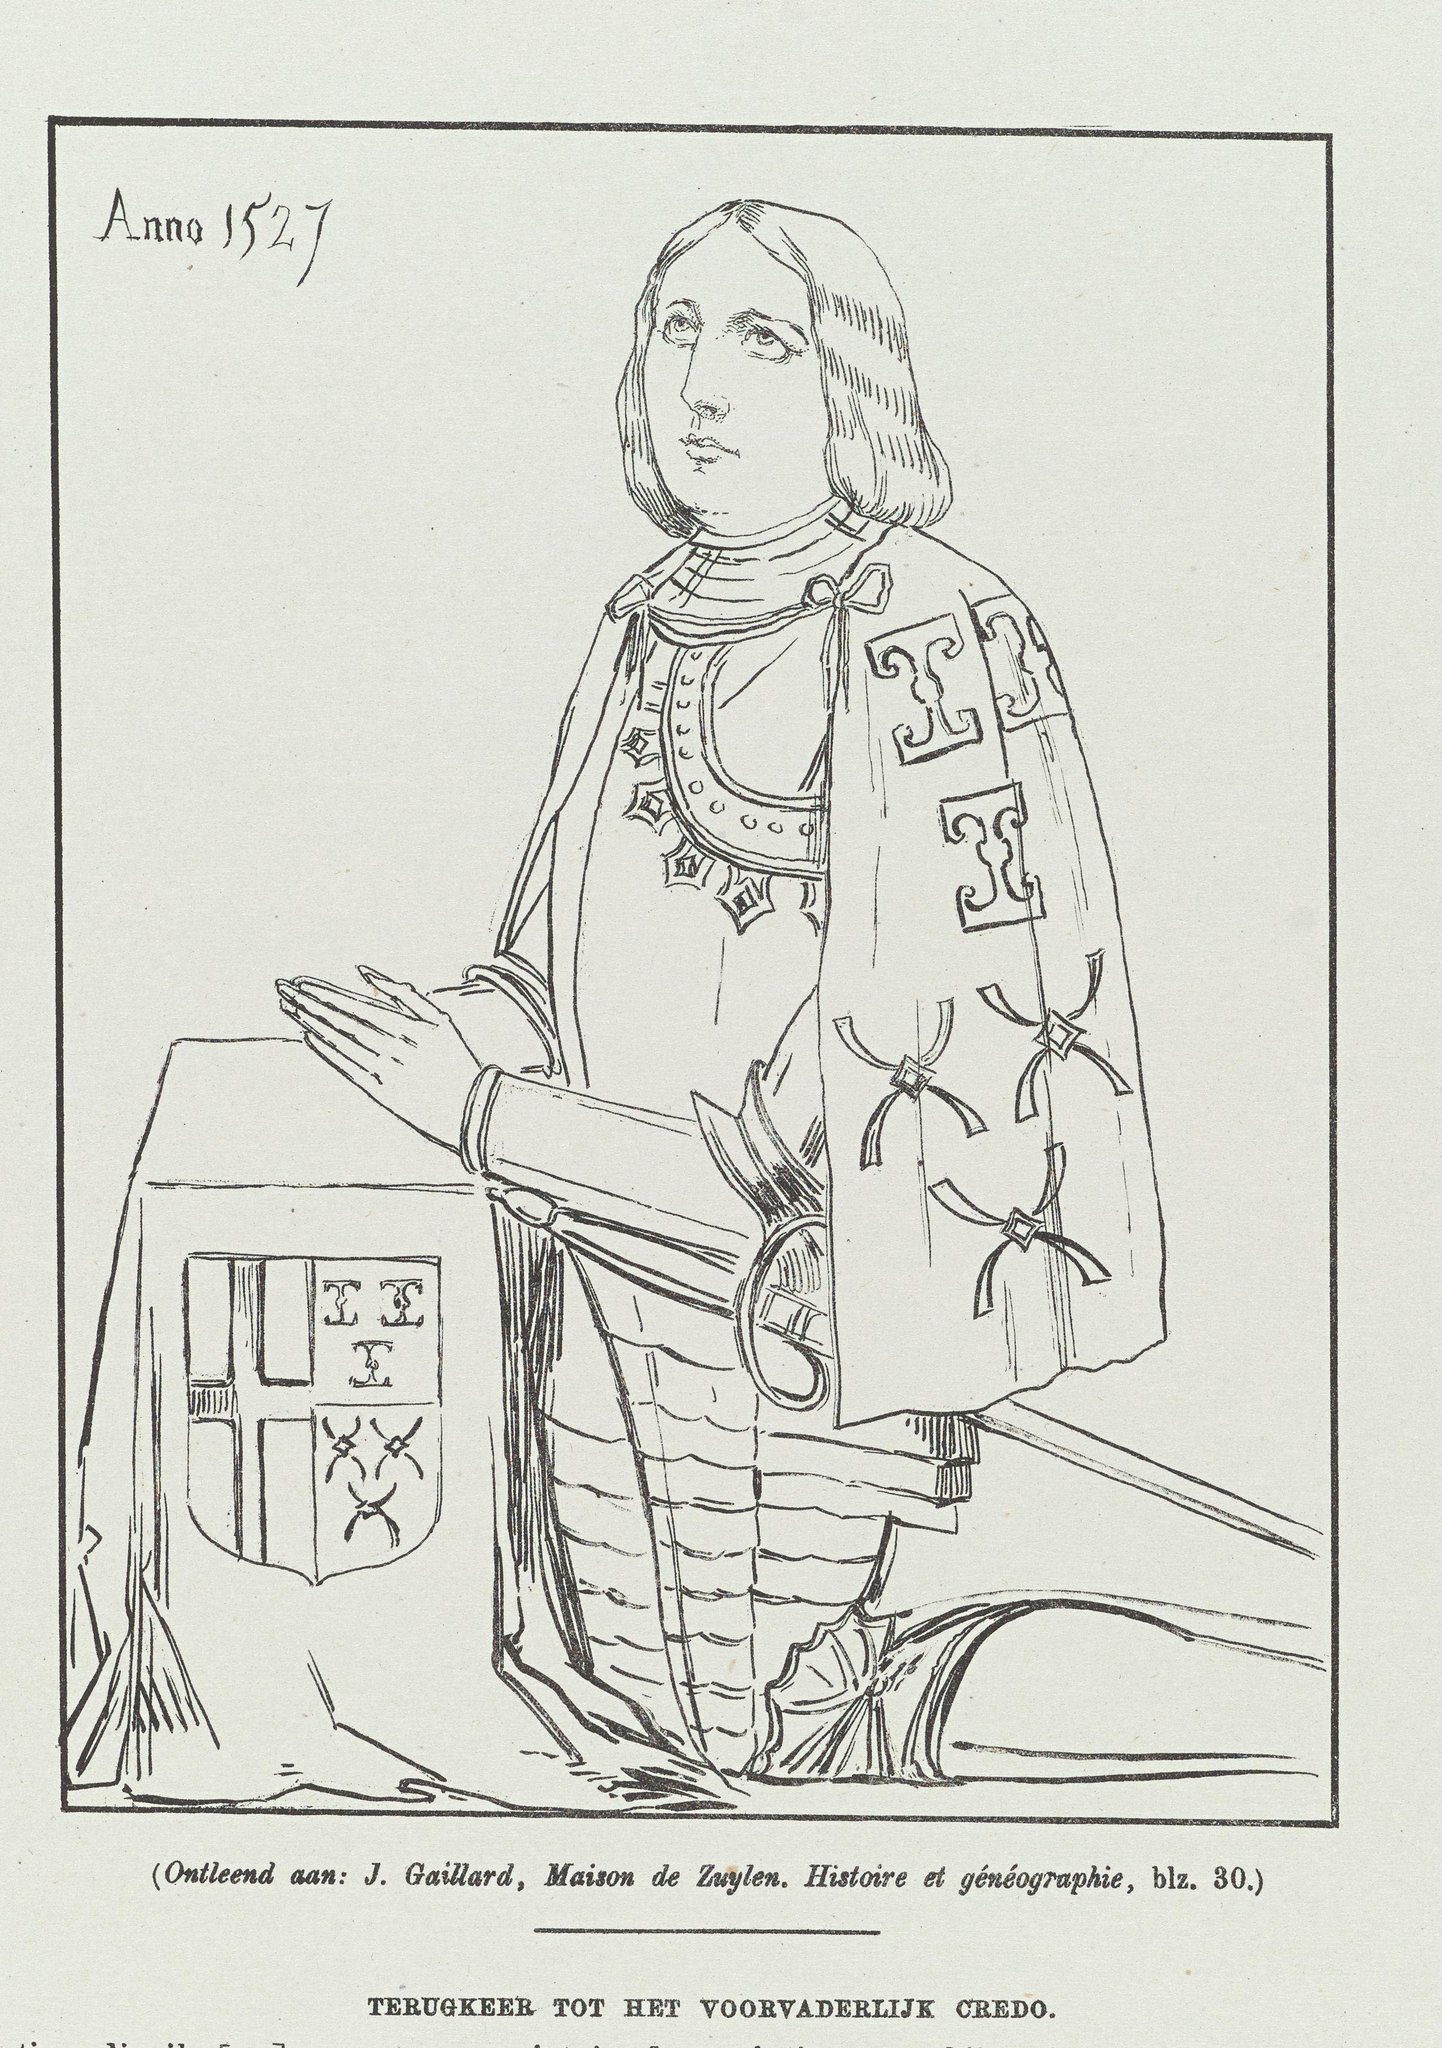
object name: print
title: Spotprent op de redevoering van Baron van Zuylen van Nijevelt in de Tweede Kamer, 1864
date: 1864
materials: paper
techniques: lithograph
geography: arnhem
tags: minister van buitenlandse zaken, kamerlid, jacob pieter pompejus van zuylen van nijevelt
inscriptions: collector's mark: Lugt 2228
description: Spotprent op de redevoering van Baron van Zuylen van Nijevelt in de Tweede Kamer over Godsdienstscholen. Middeleeuws portret van een knielende ridder uit het huis van Zuylen van Nijevelt uit 1527. Plaat verschenen bij het weekblad De Nederlandsche Spectator, nr. 25, 18 juni 1864.